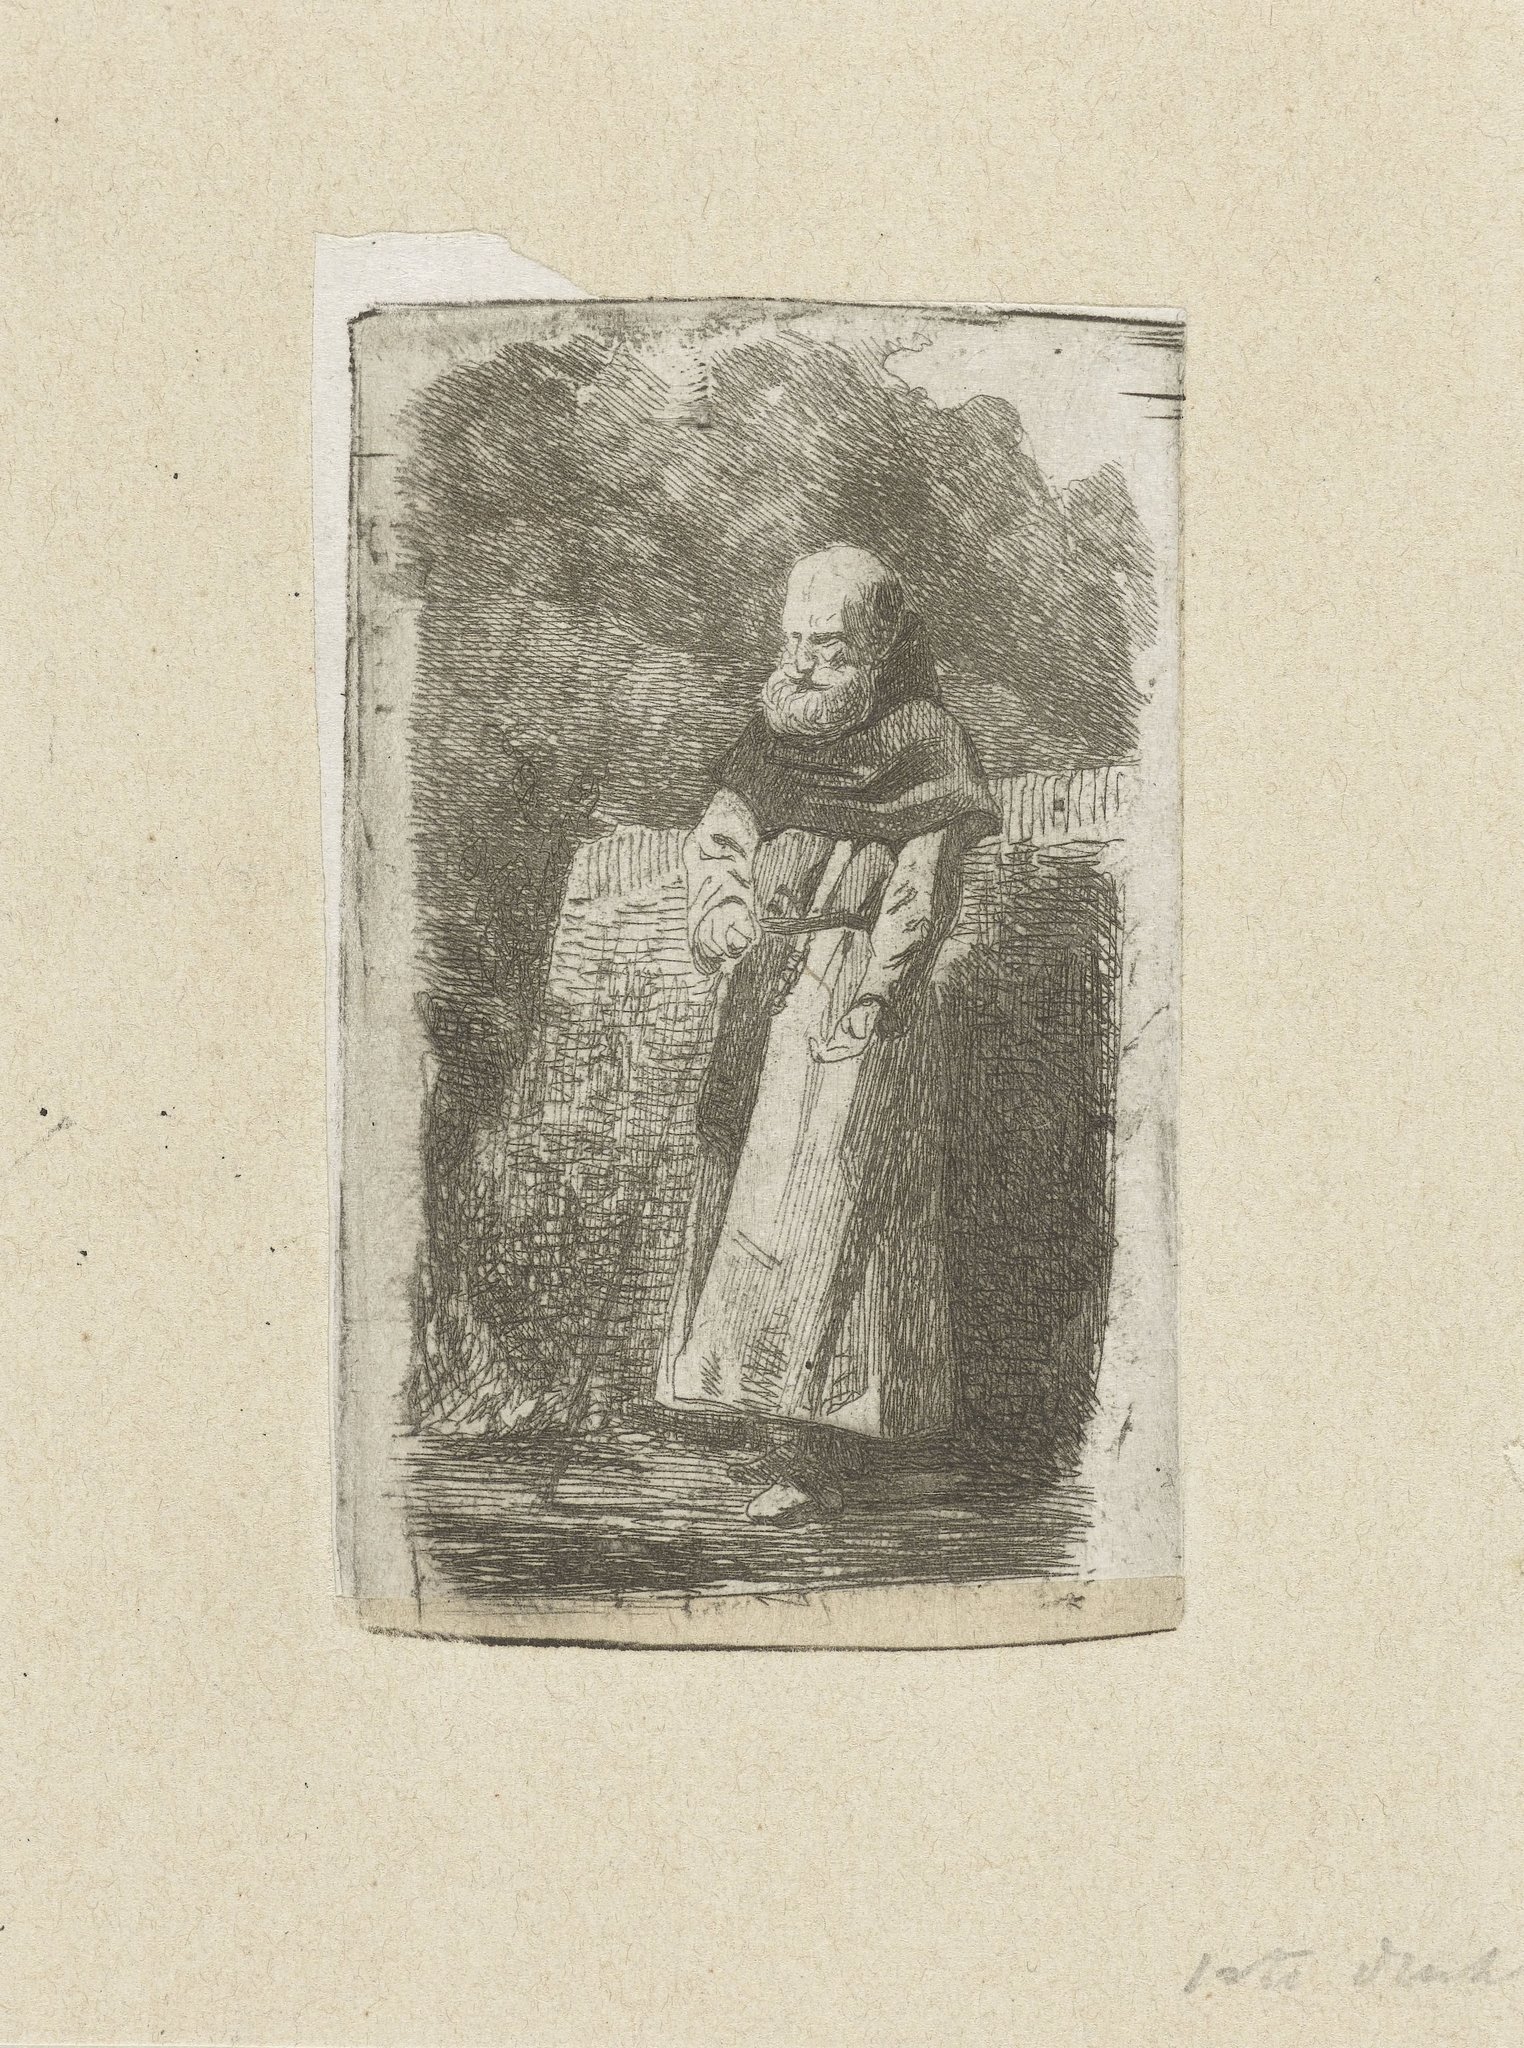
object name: print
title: Monnik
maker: lambertus hardenberg (1822-1900)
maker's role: draughtsman, painter, print maker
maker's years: 1822-1900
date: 1837-1900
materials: paper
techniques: etching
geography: the hague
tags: monk(s), friar(s)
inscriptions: collector's mark: Lugt 2228